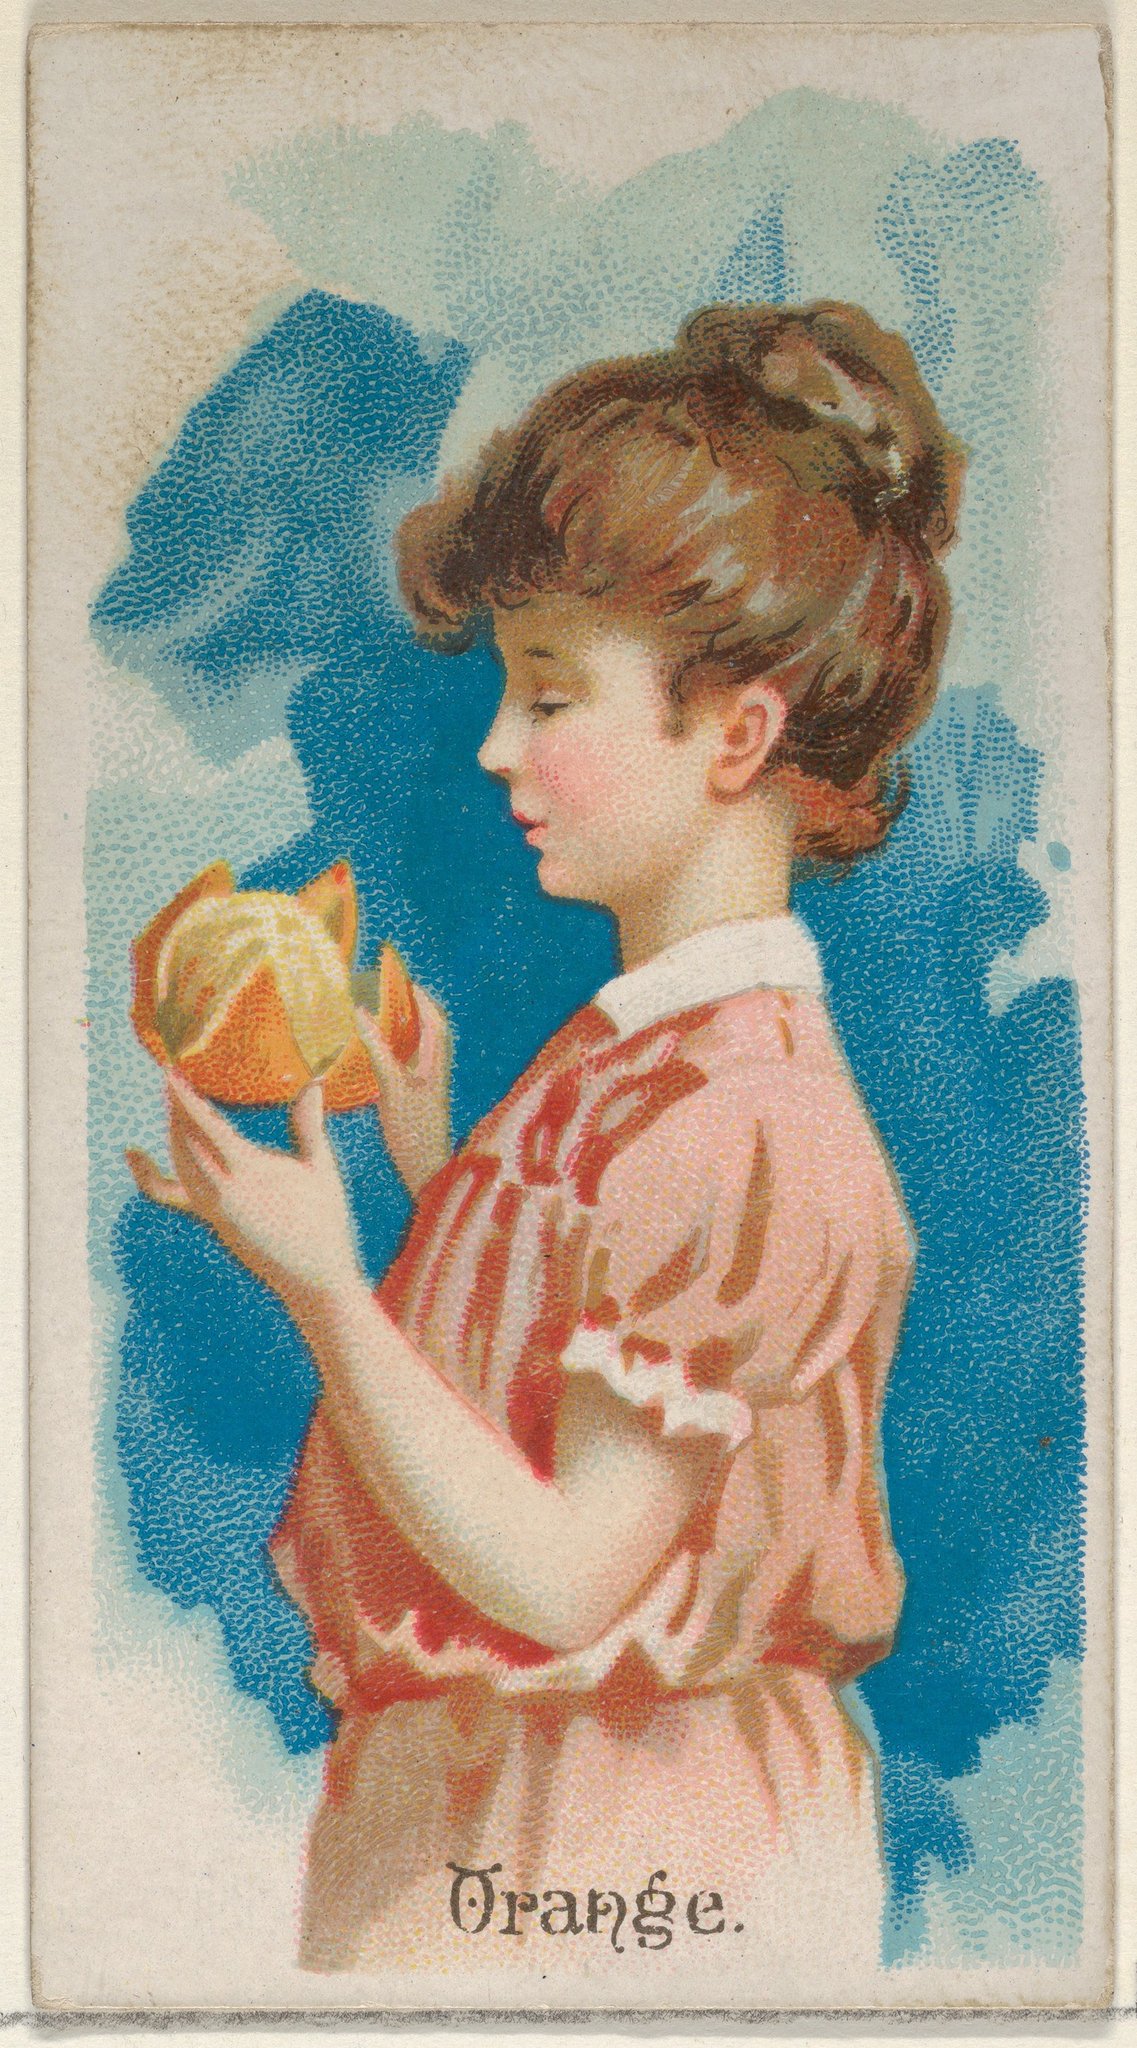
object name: print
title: Orange, from the Fruits series (N12) for Allen & Ginter Cigarettes Brands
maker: allen & ginter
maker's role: publisher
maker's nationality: american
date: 1891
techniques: color lithograph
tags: fruit,girls,profiles